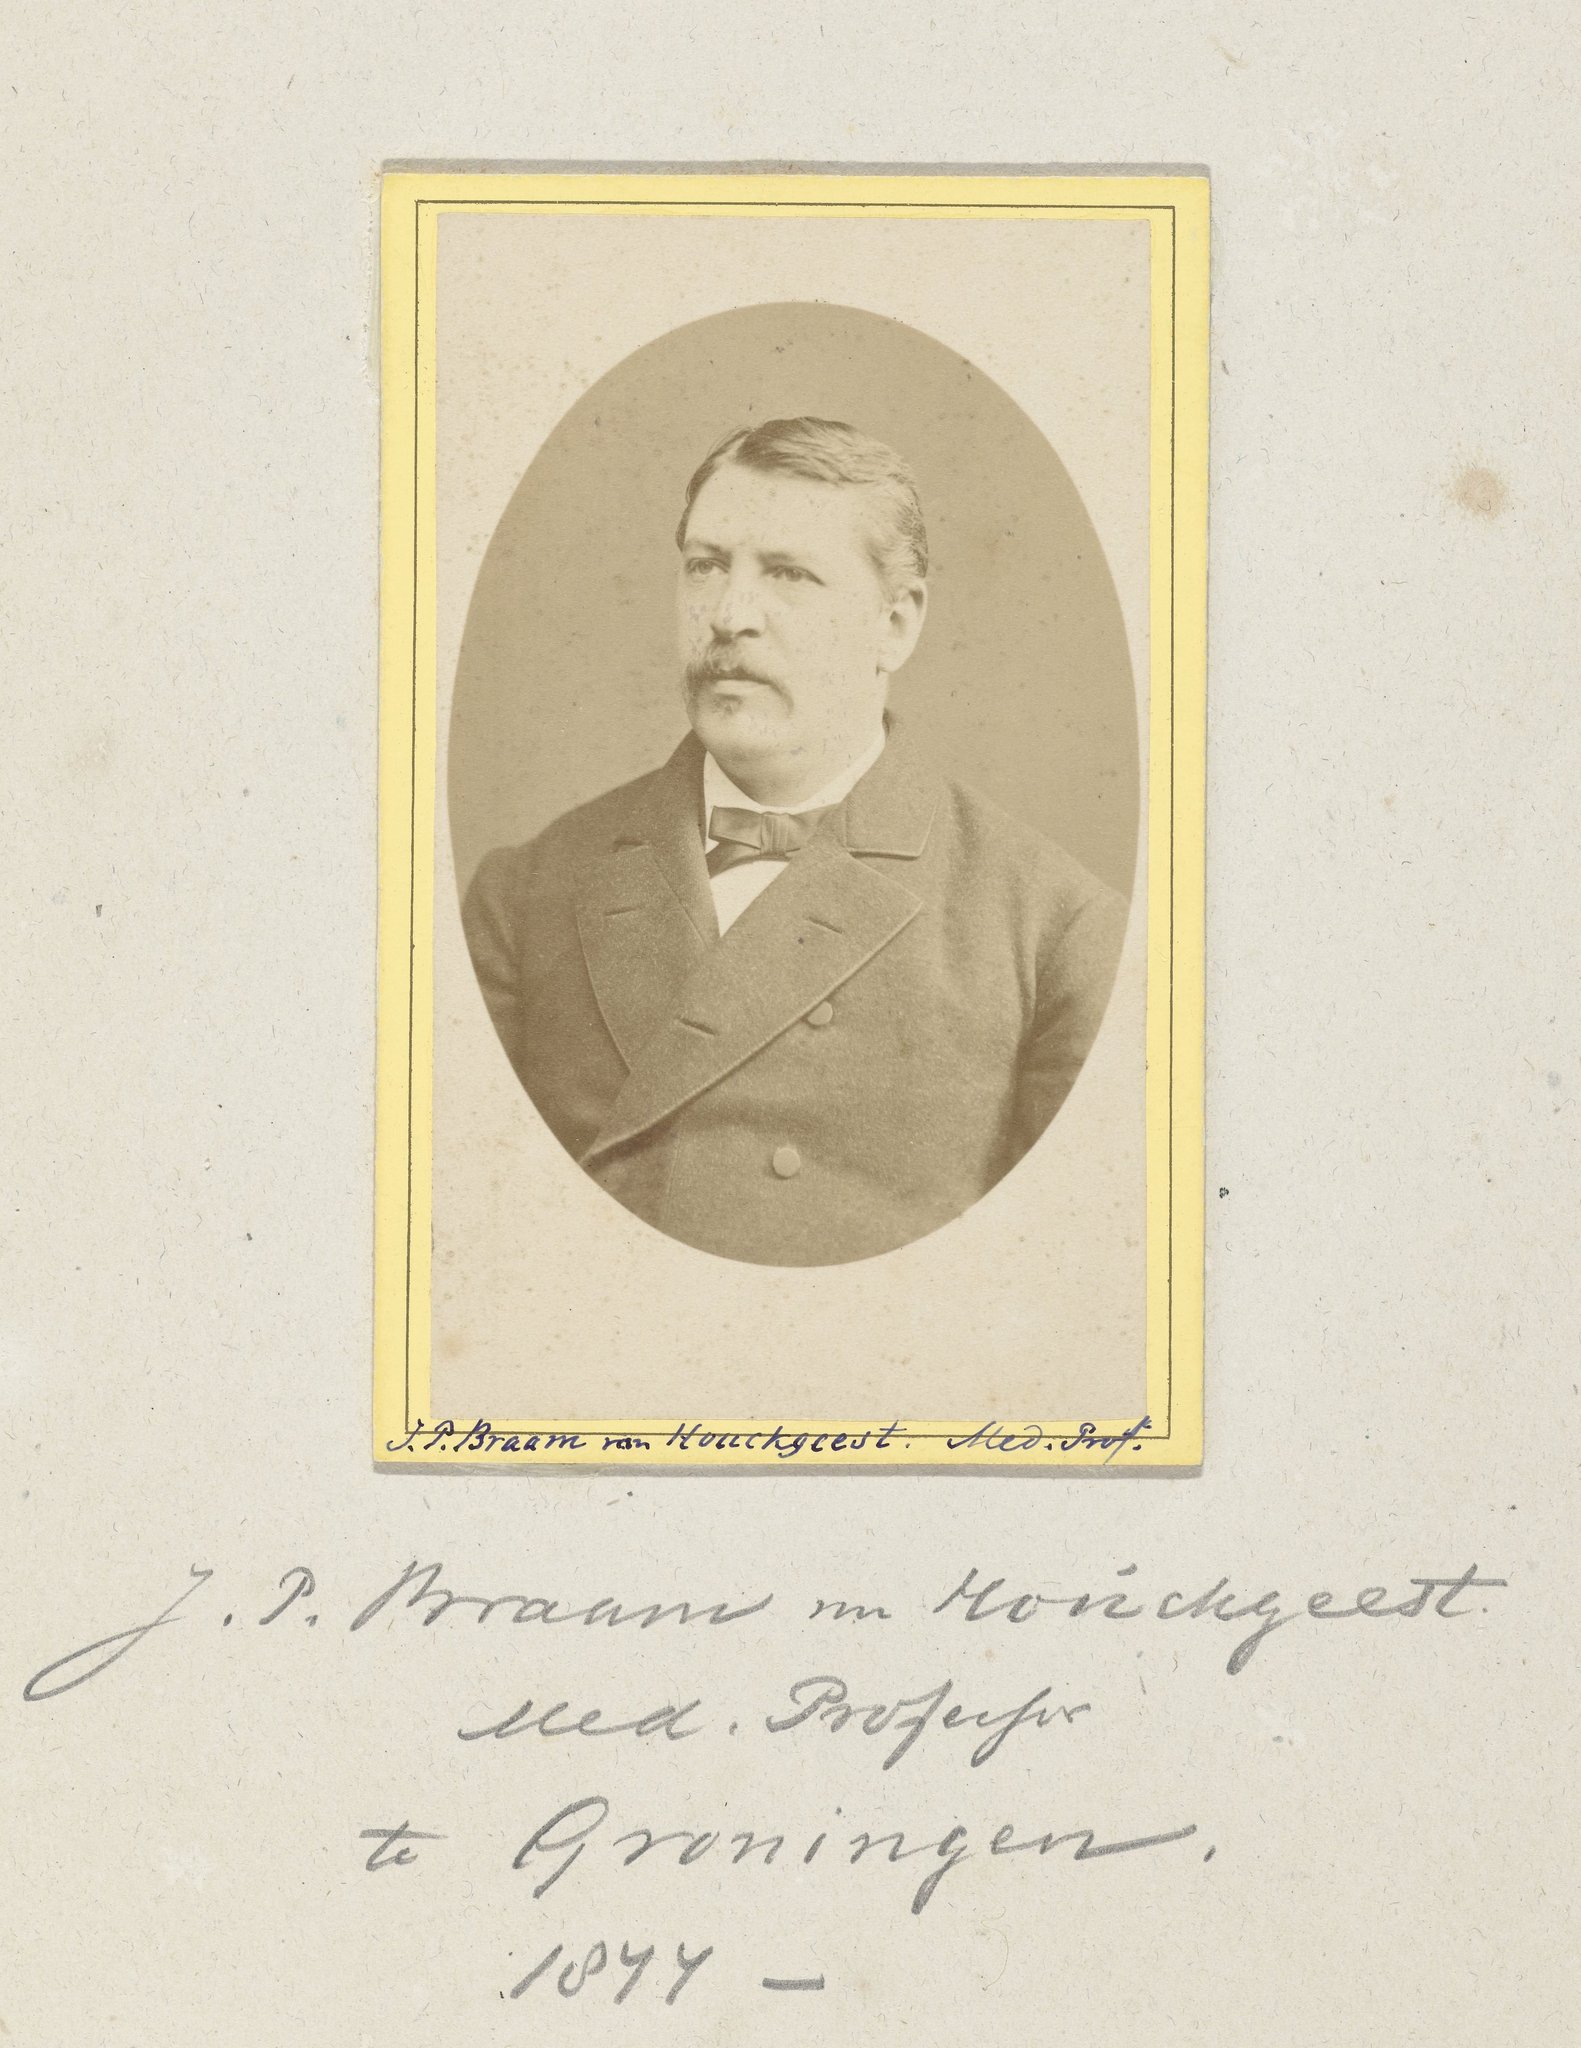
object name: photograph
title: Portret van medisch professor J.P. Braam van Houckgeest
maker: Anonymous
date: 1860-1880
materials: paper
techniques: albumen print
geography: netherlands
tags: historical persons (portraits and scenes from the life)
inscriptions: name: ‘J.P. Braam van Houckgeest, med. prof. te Groningen 1844 - 18’